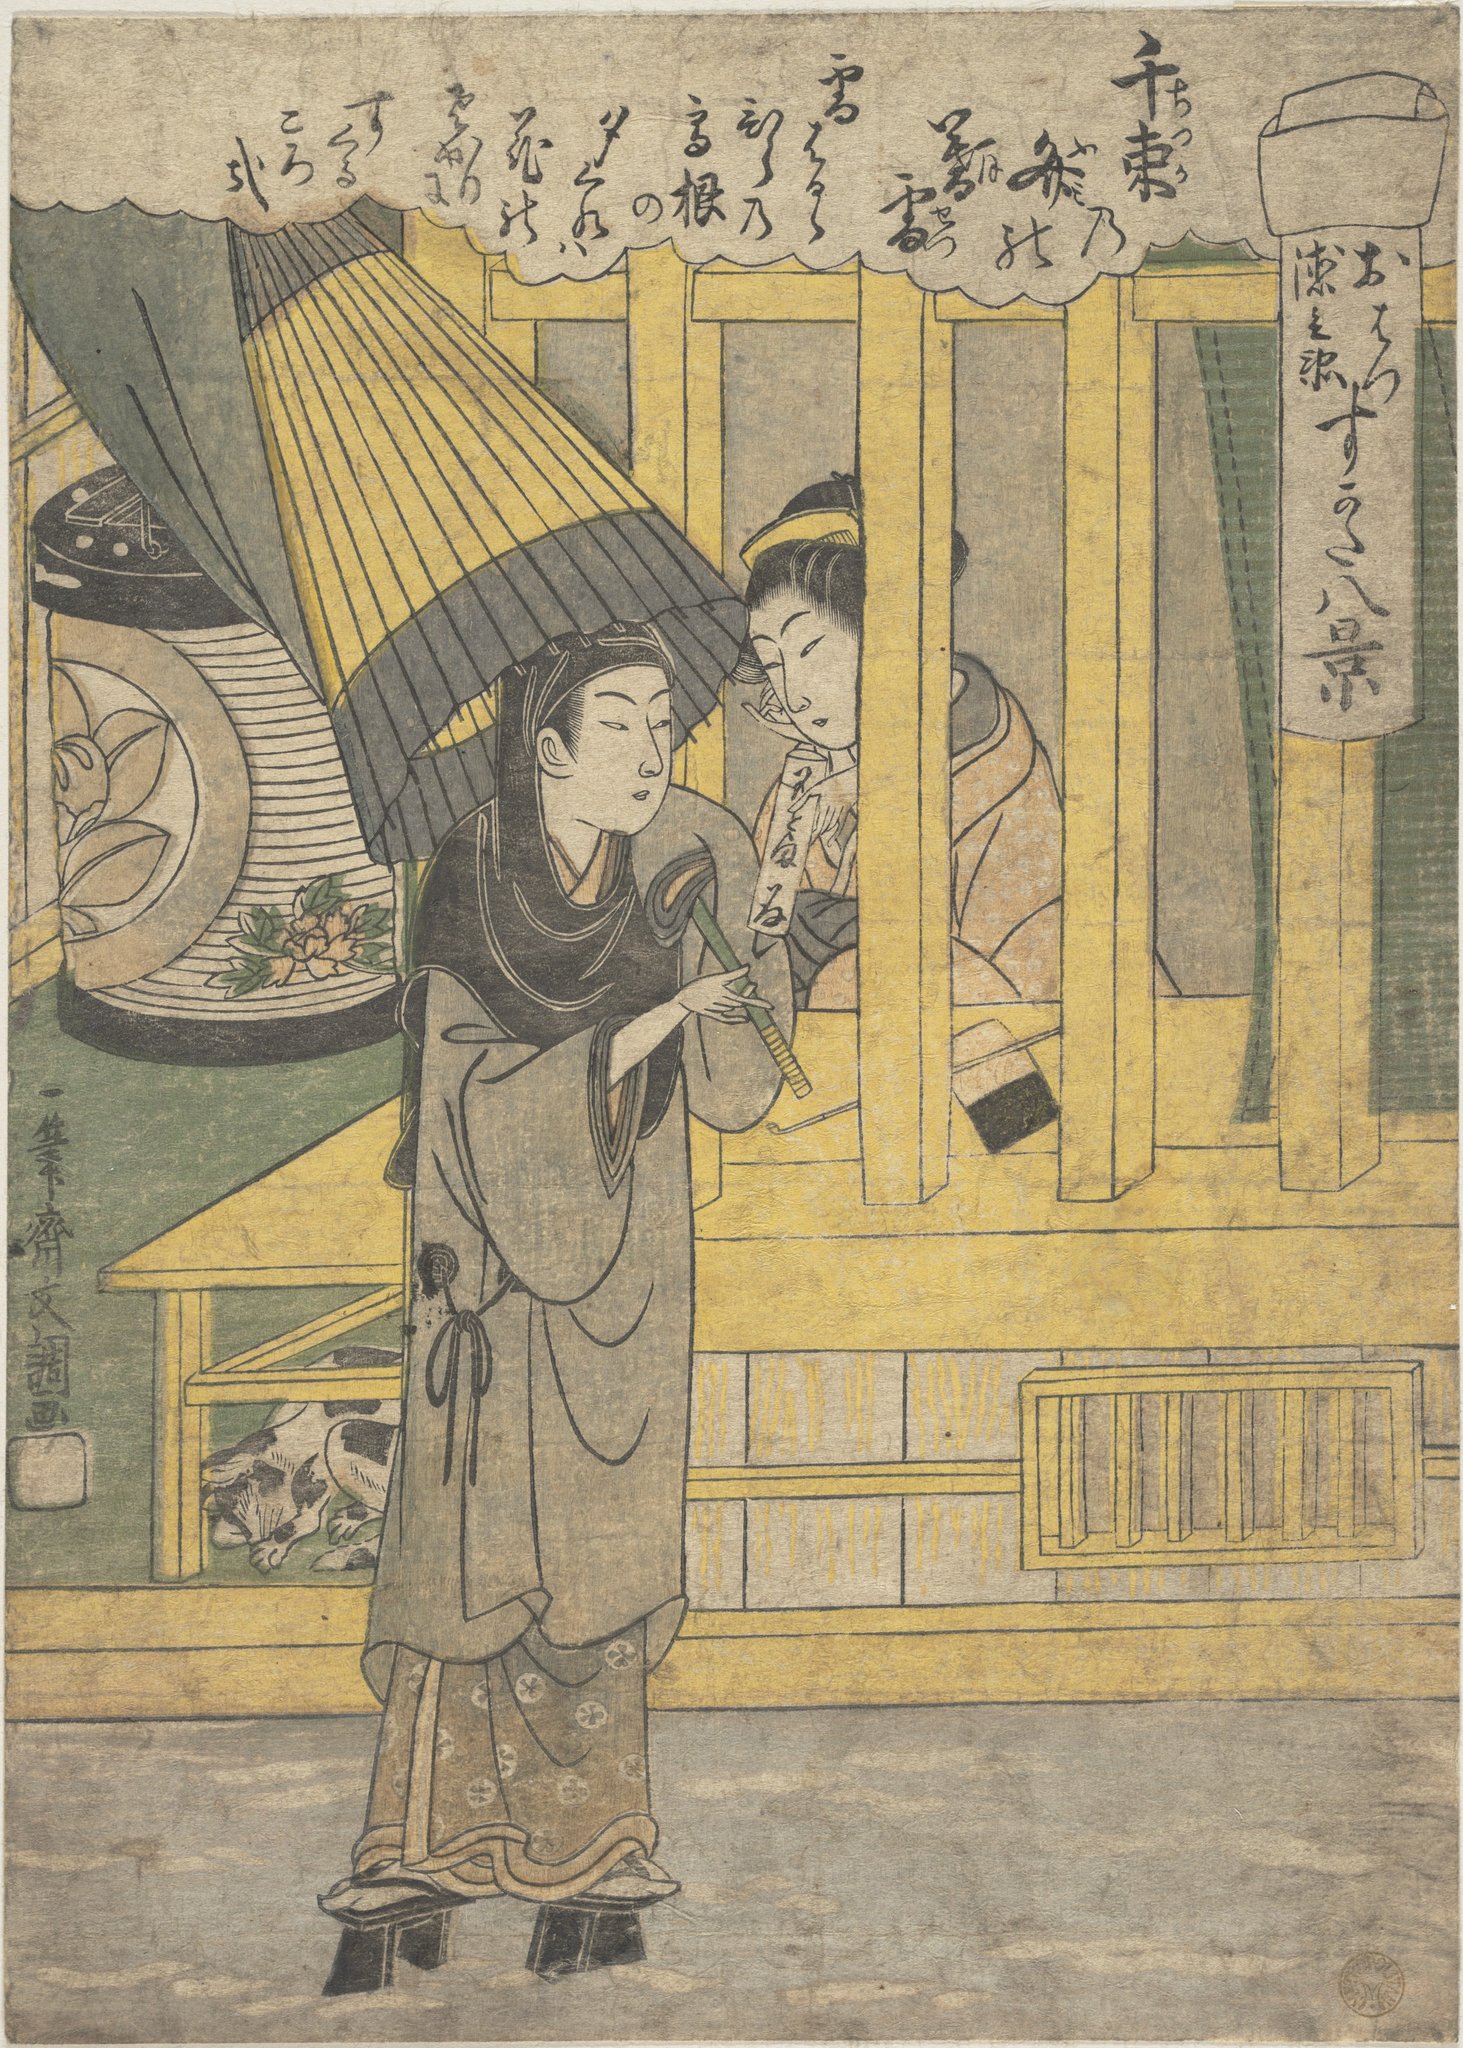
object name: print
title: The Lovers O-Hatsu and Tokubei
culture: japanese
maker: ippitsusai bunchō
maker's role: artist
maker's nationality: japanese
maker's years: 1765-1792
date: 1770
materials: ink, paper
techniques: woodblock print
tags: couples,men,women,cats